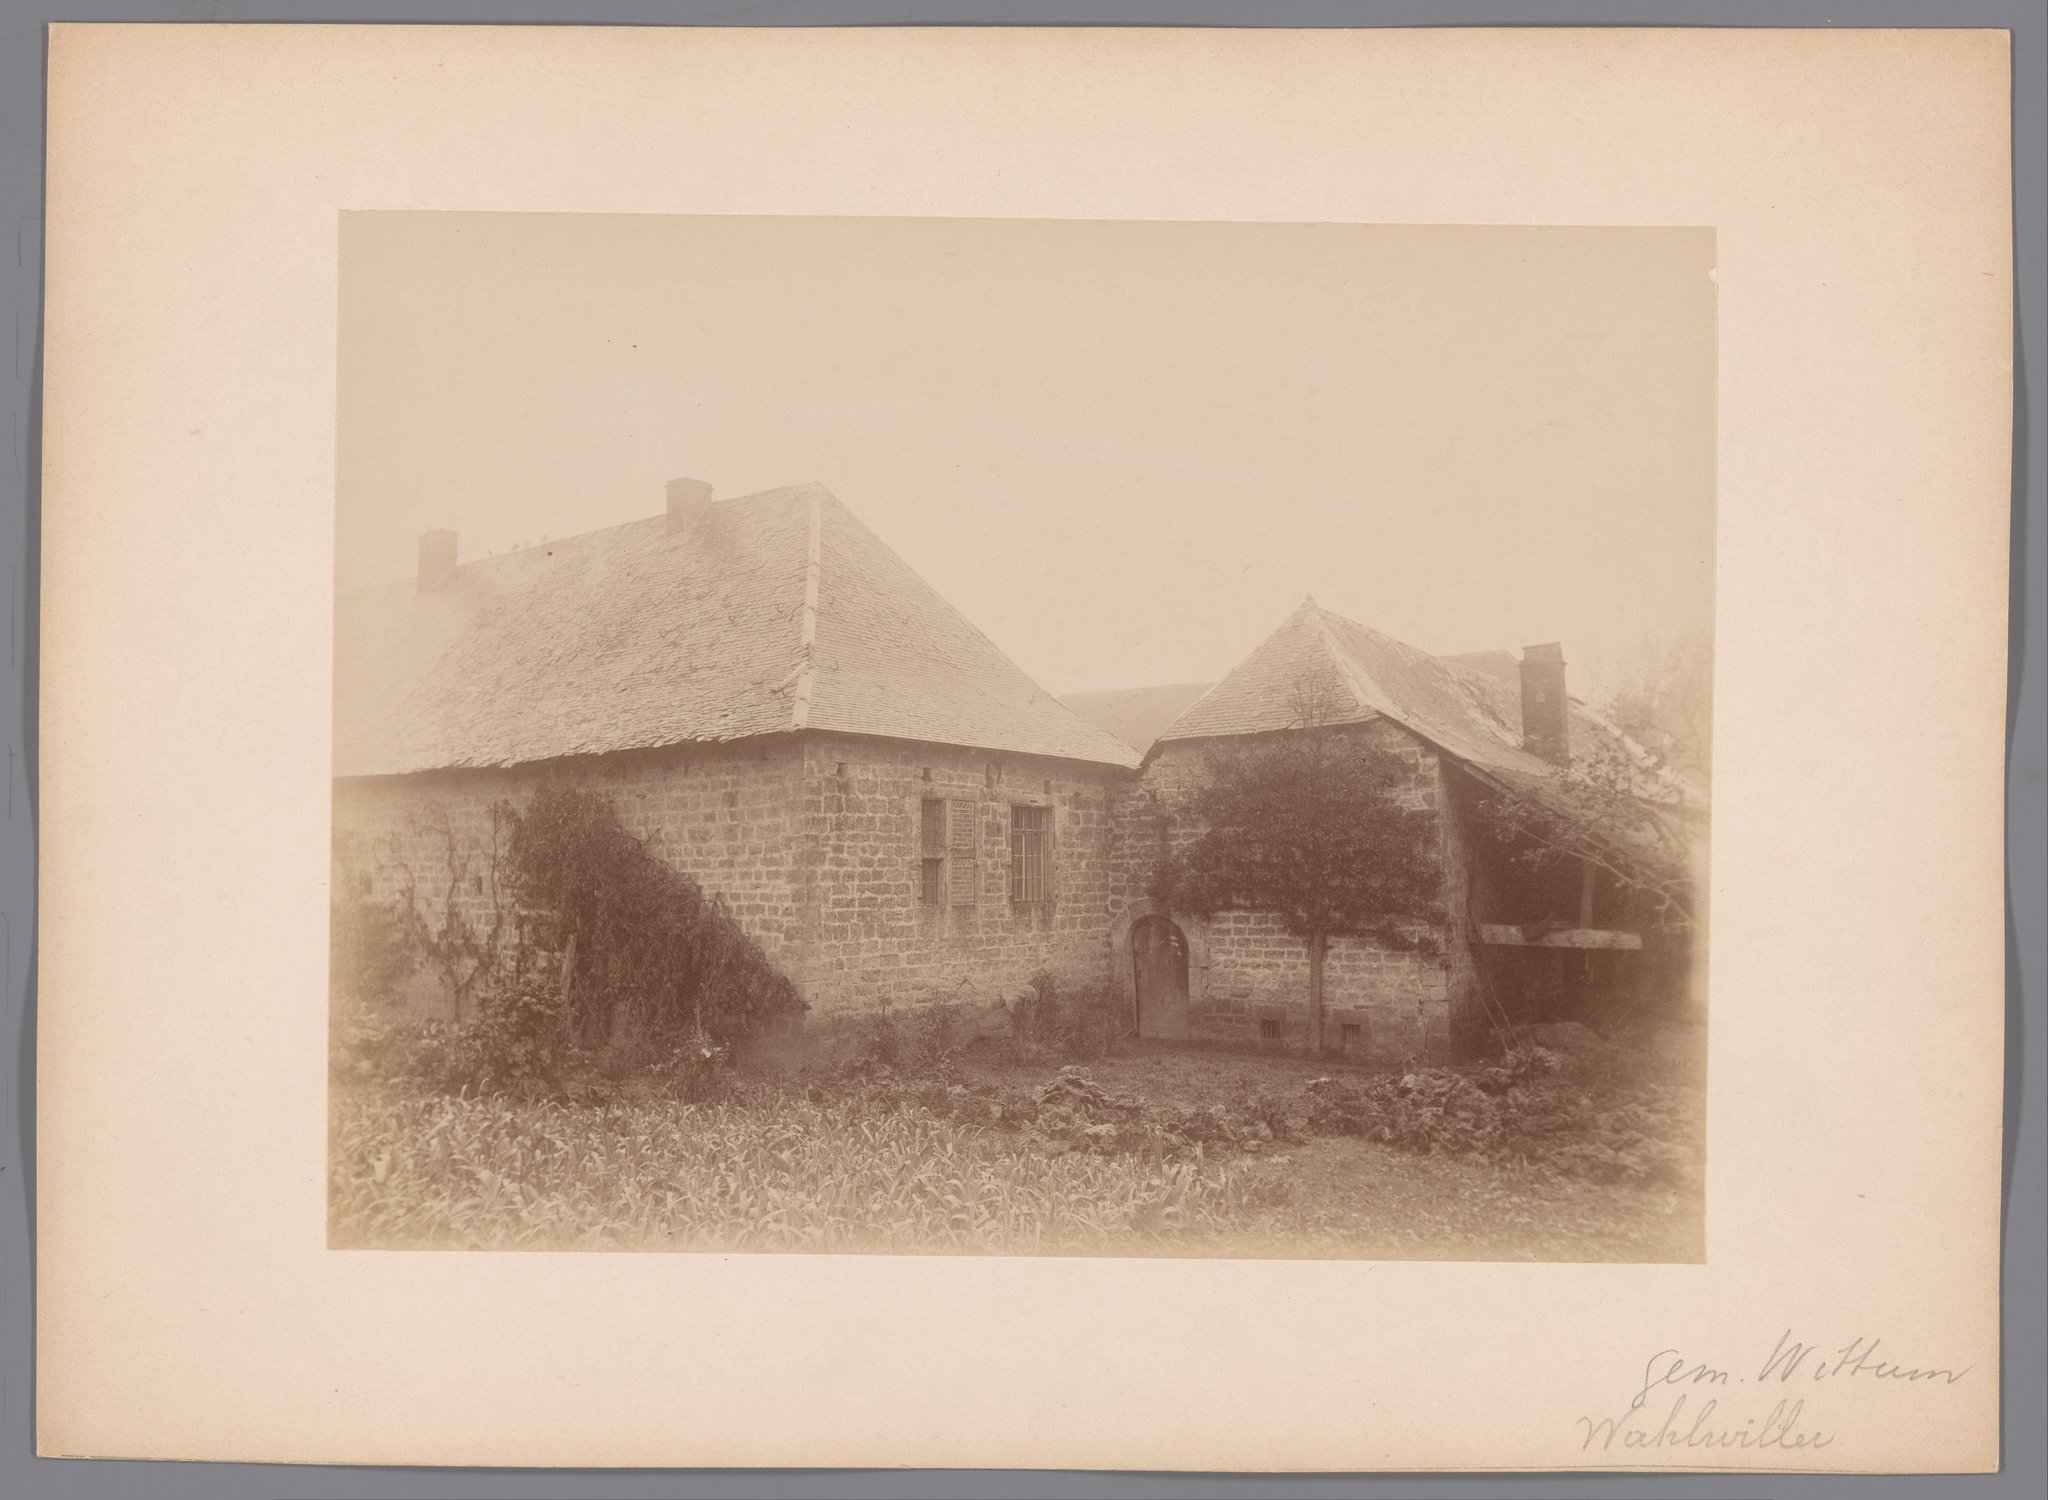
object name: photograph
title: Gezicht op boerderij Leyenhof te Wahlwiller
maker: anoniem (monumentenzorg)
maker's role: fotograaf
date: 1890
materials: cardboard, photographic support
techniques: albumen print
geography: wahlwiller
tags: farm (building)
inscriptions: annotation: ‘De boerderij Leyenhof te Wahlwiller/ geph. - 25 oct 1890 afgebrand 31 oct 1890’, annotation: ‘Gem. Wittum/ Wahlwiller’